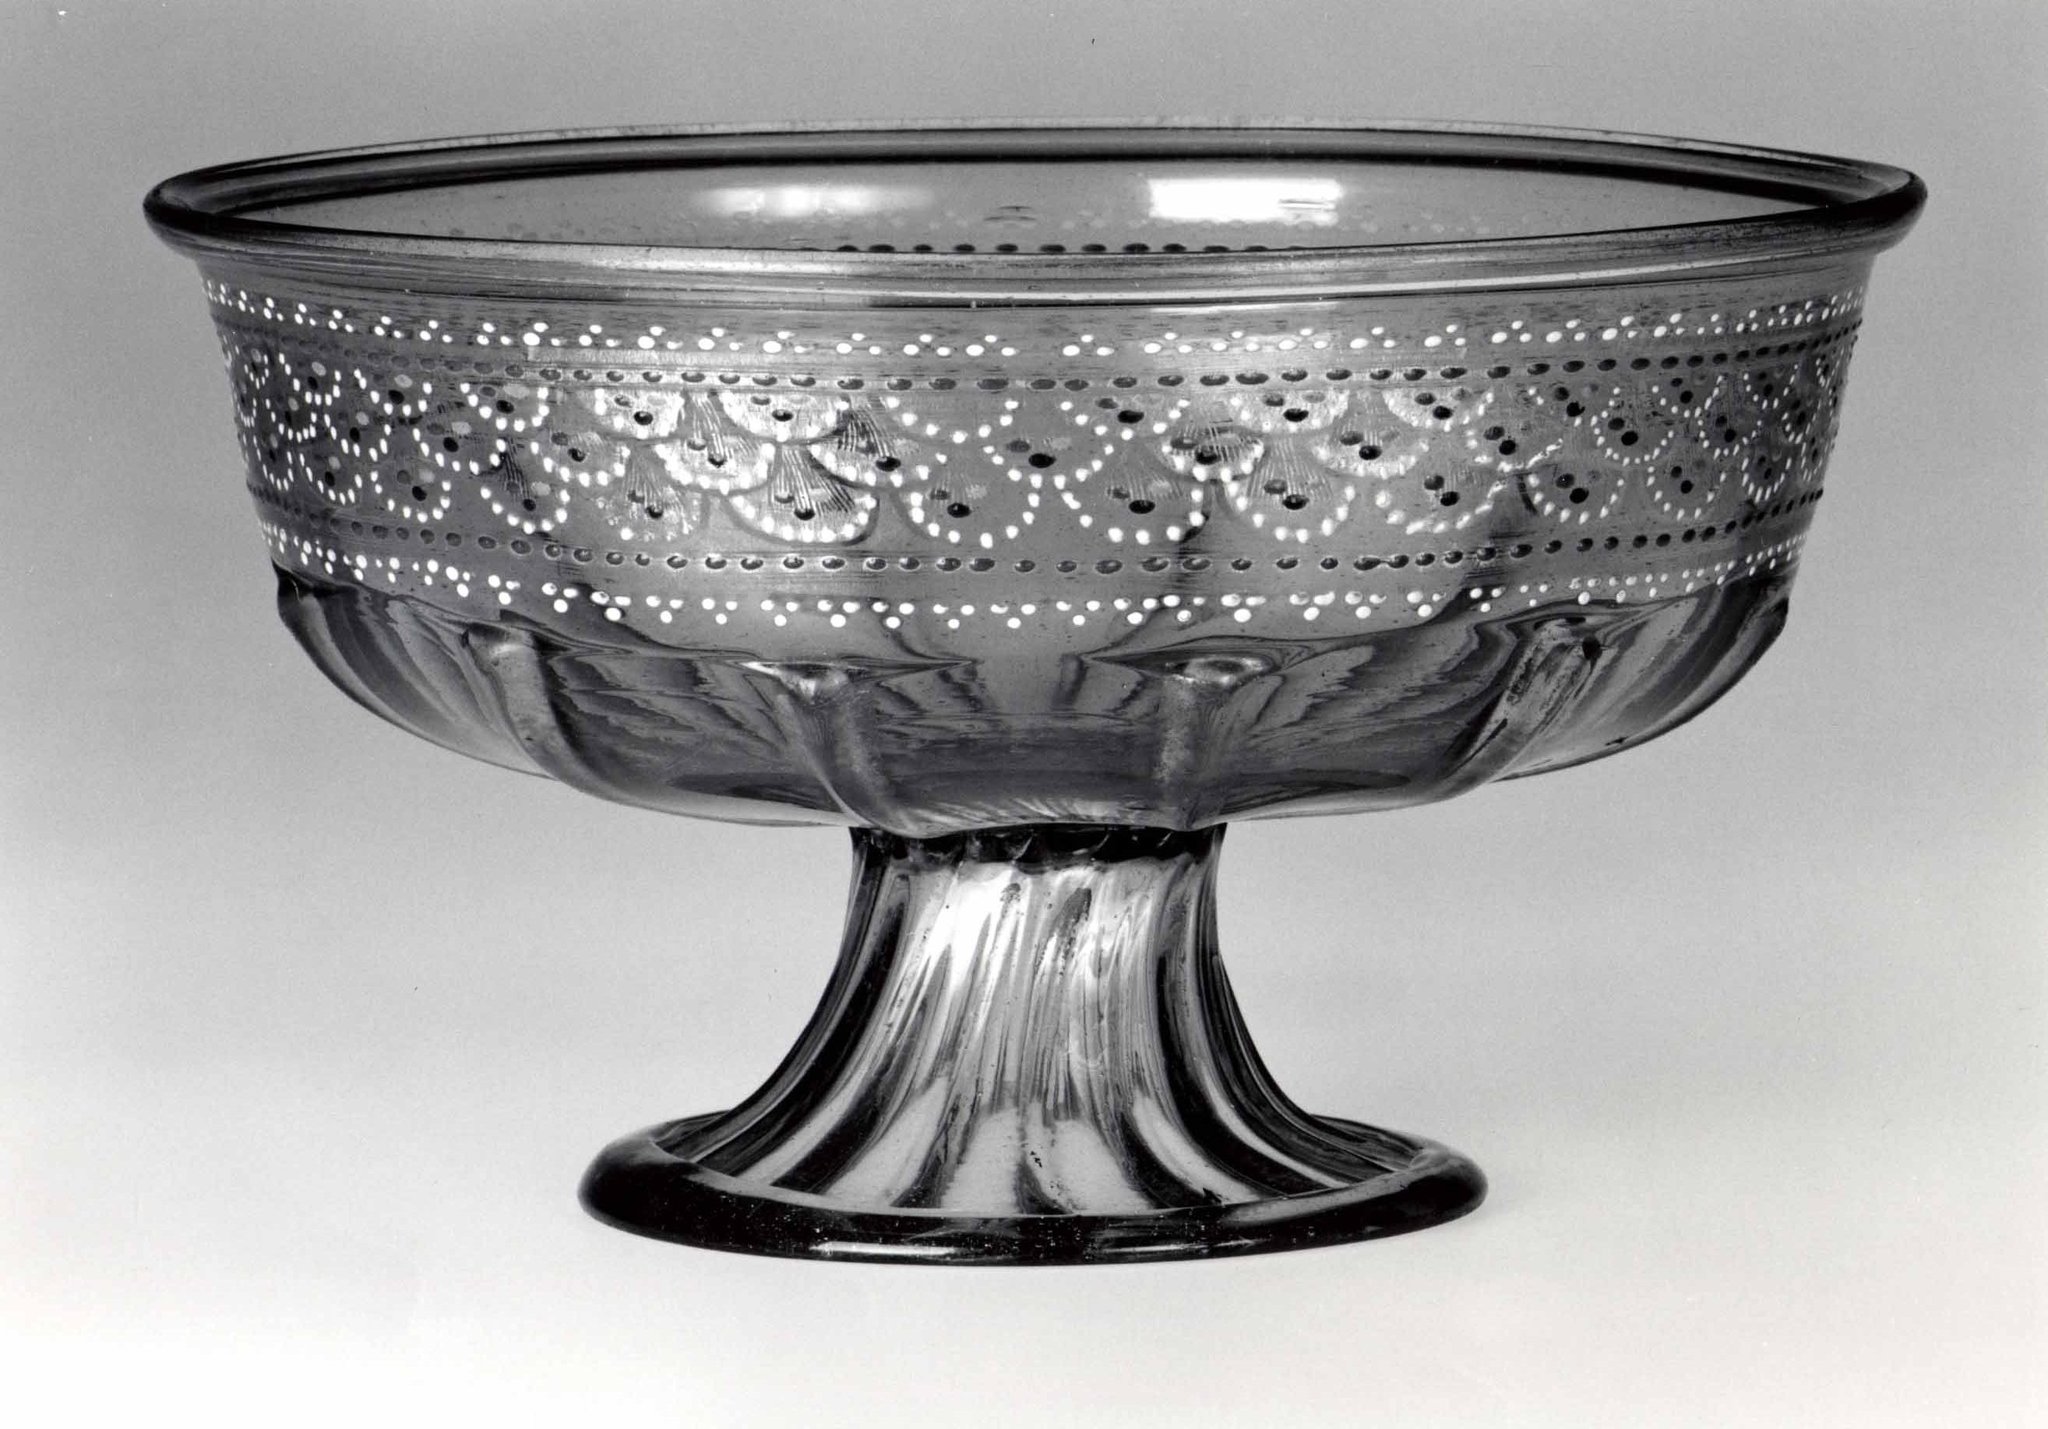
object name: bowl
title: Footed bowl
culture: italian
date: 1500-1525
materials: gilt, glass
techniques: glassblowing, enamel, molding